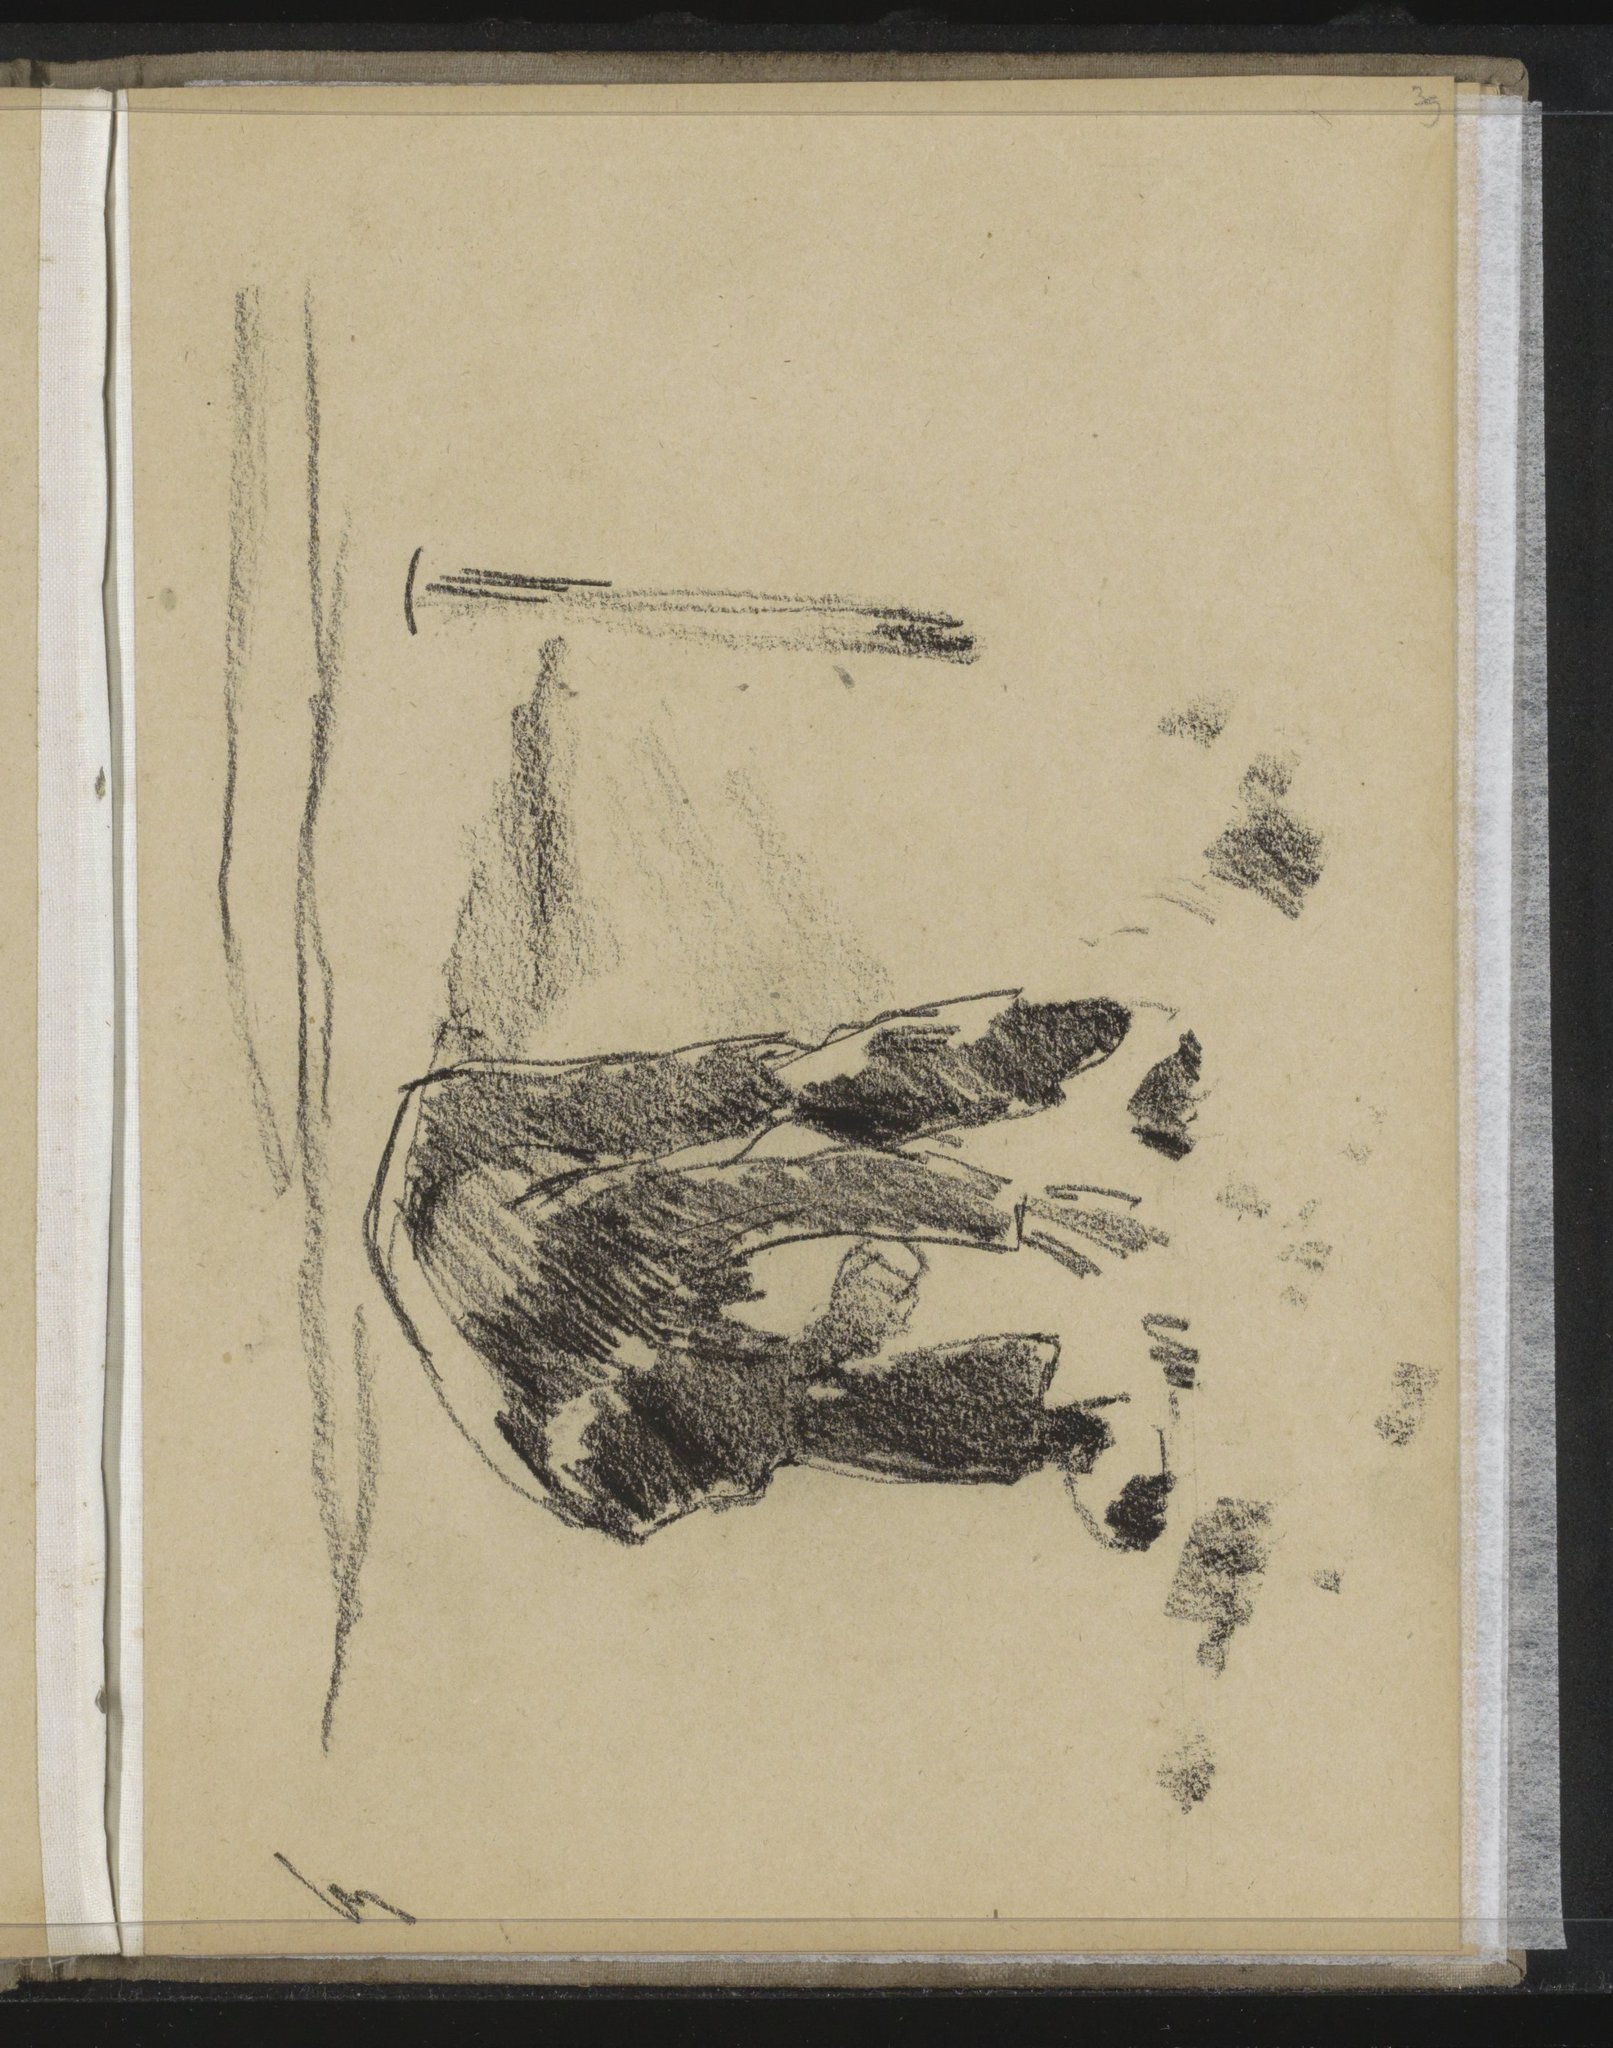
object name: sketchbook leaf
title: Bukkende boer op het land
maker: willem witsen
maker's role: draughtsman, painter, print maker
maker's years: 1860-1923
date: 1893-1897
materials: chalk, paper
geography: ede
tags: farmers, cultivated land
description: Pagina 39 uit een schetsboek met 28 bladen.